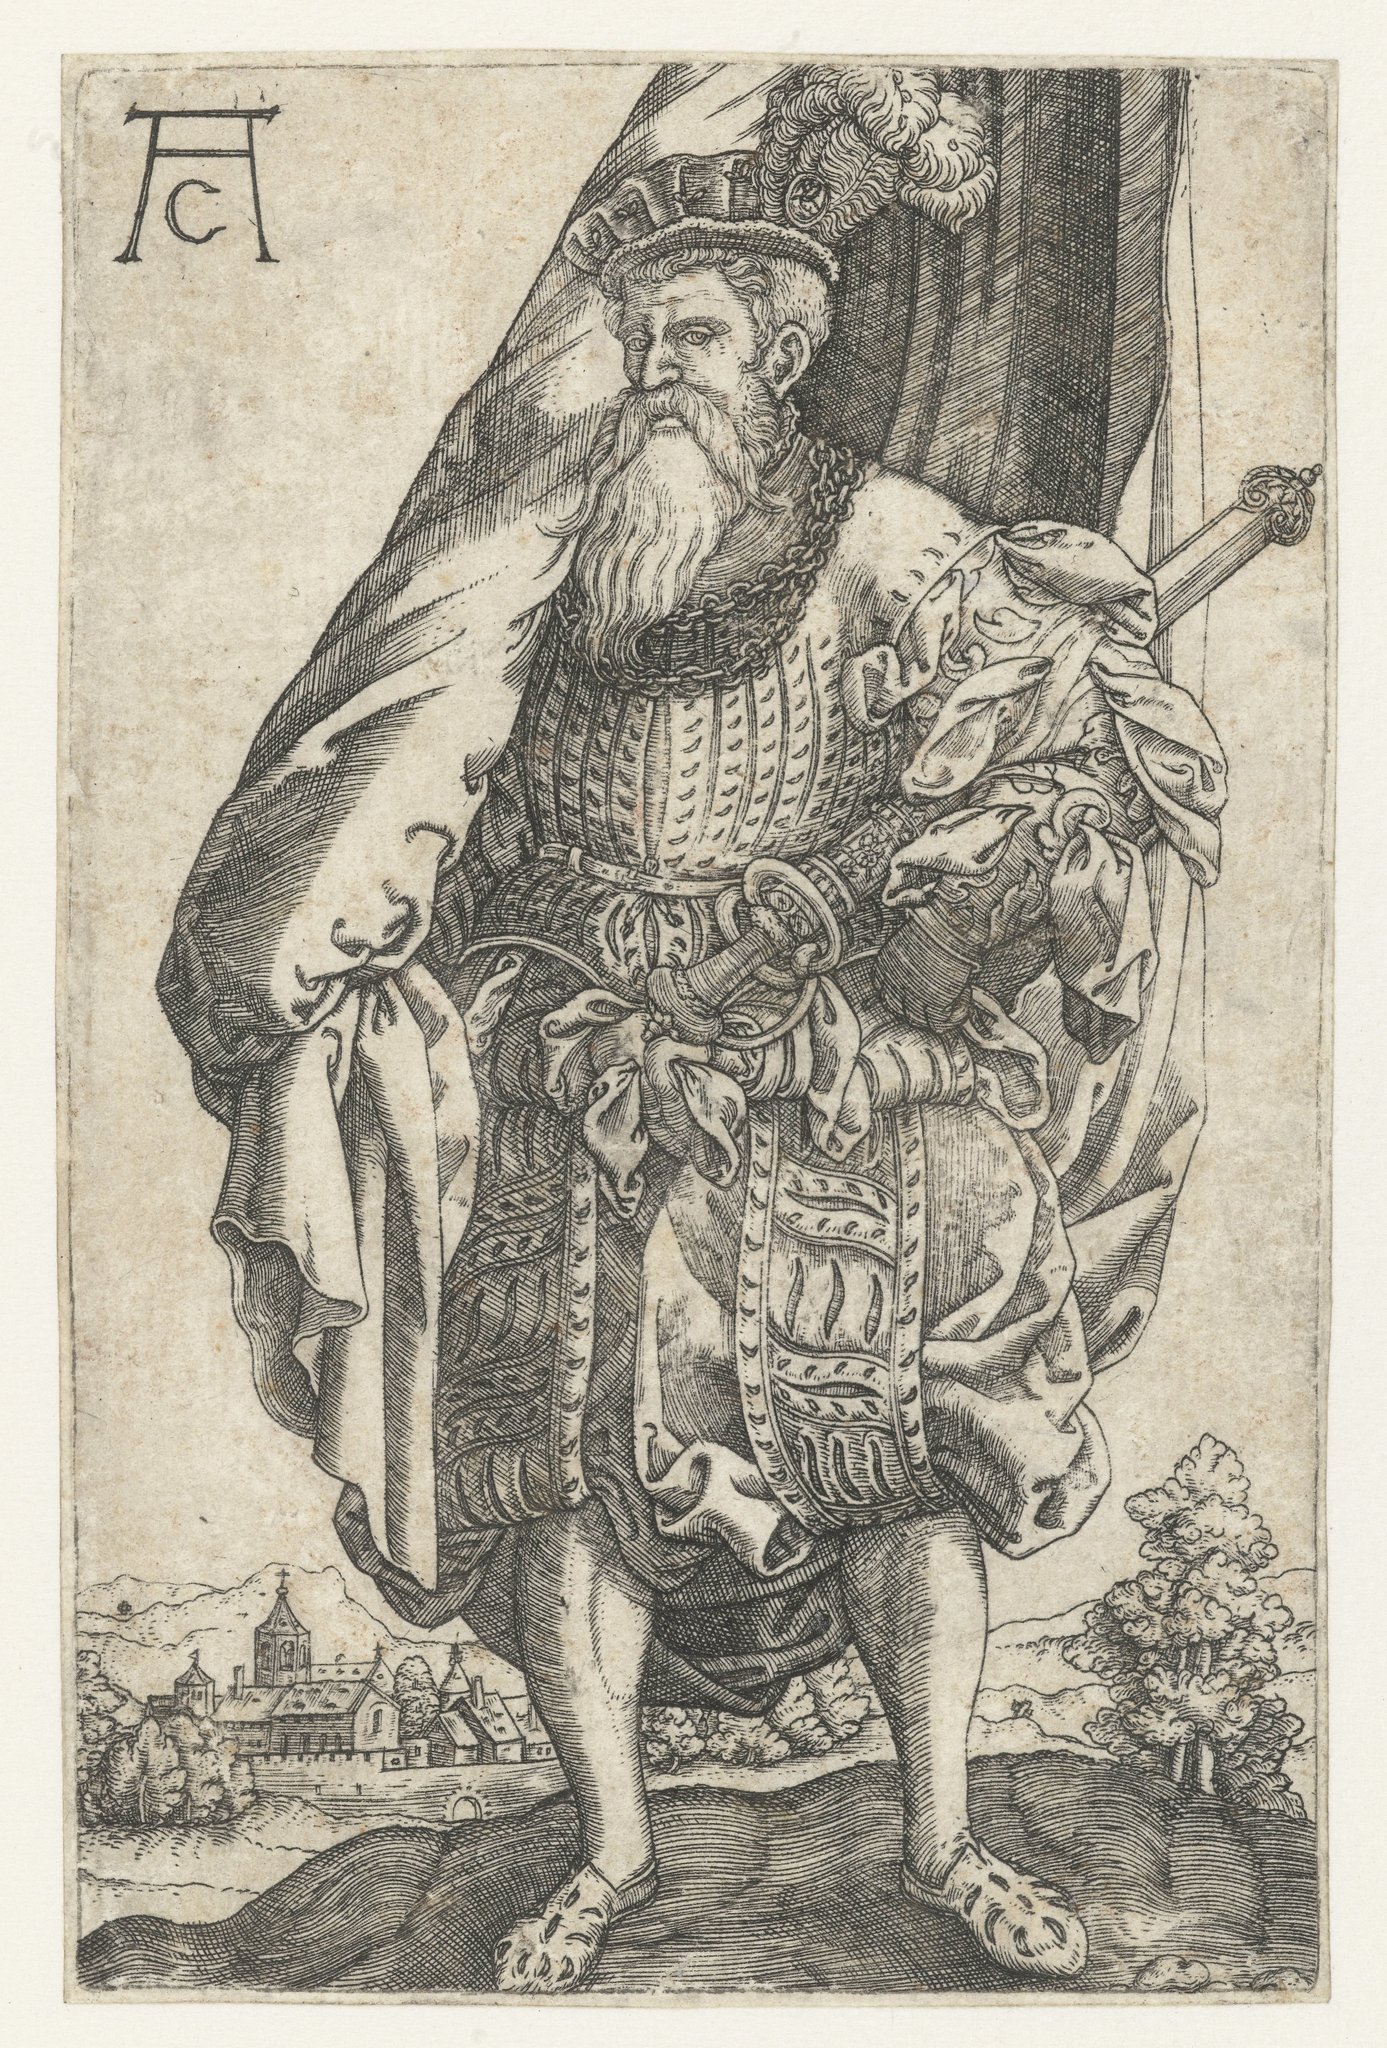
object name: print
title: Standaarddrager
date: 1520-1562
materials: paper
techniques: engraving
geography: low countries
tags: standard-bearer, flag-bearer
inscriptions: collector's mark: Lugt 2228a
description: Man met vaandel en zwaard in schede, stad op achtergrond.